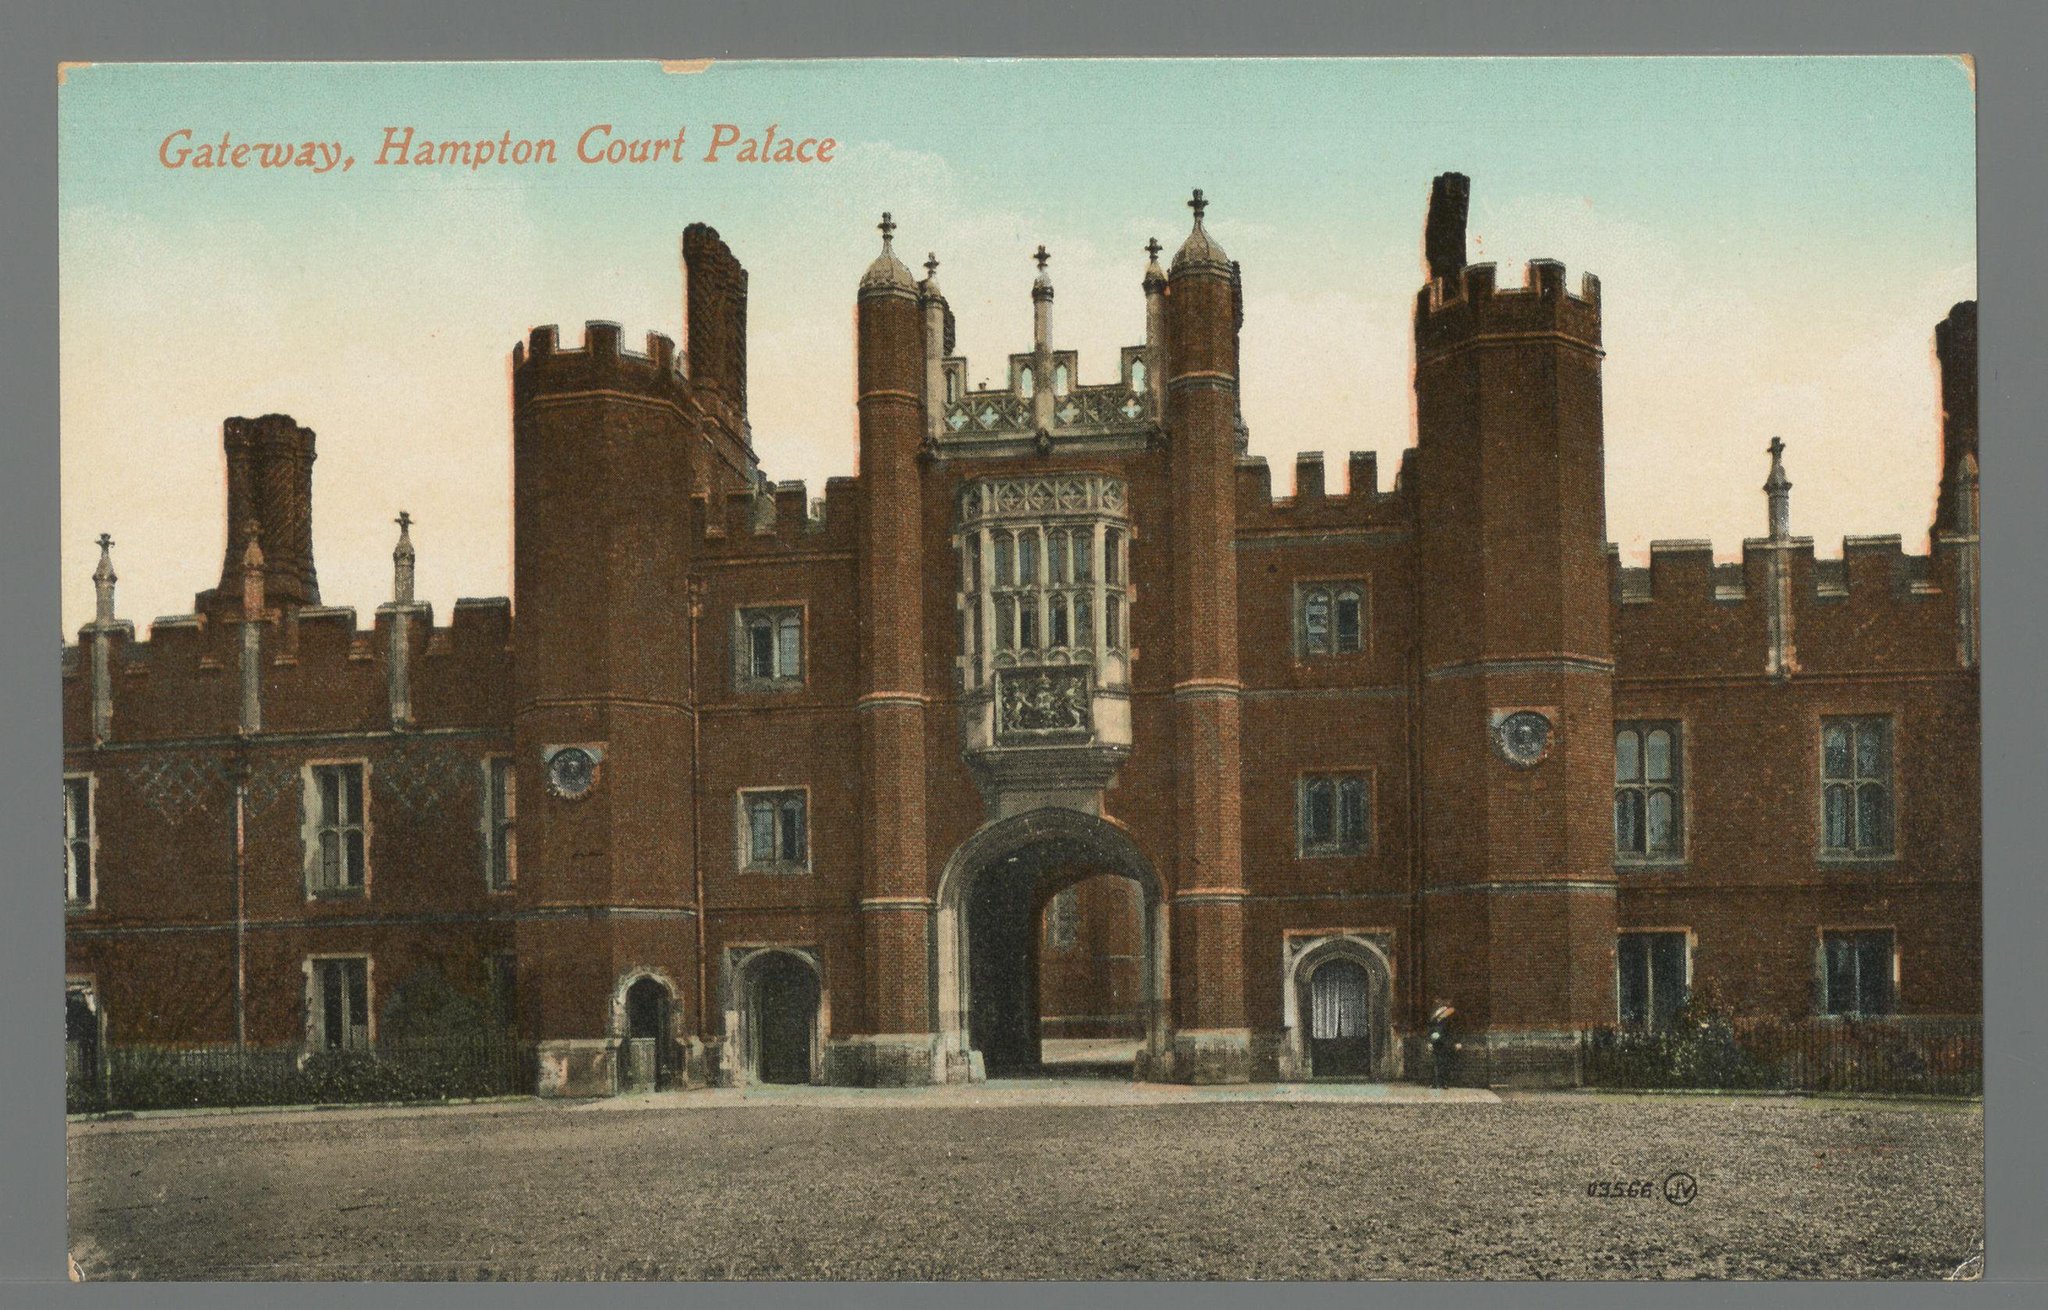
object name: ansichtkaart, prentbriefkaart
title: Gateway, Hampton Court Palace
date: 1902-1930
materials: cardboard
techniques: lithograph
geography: dundee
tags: palace, gate, entrance